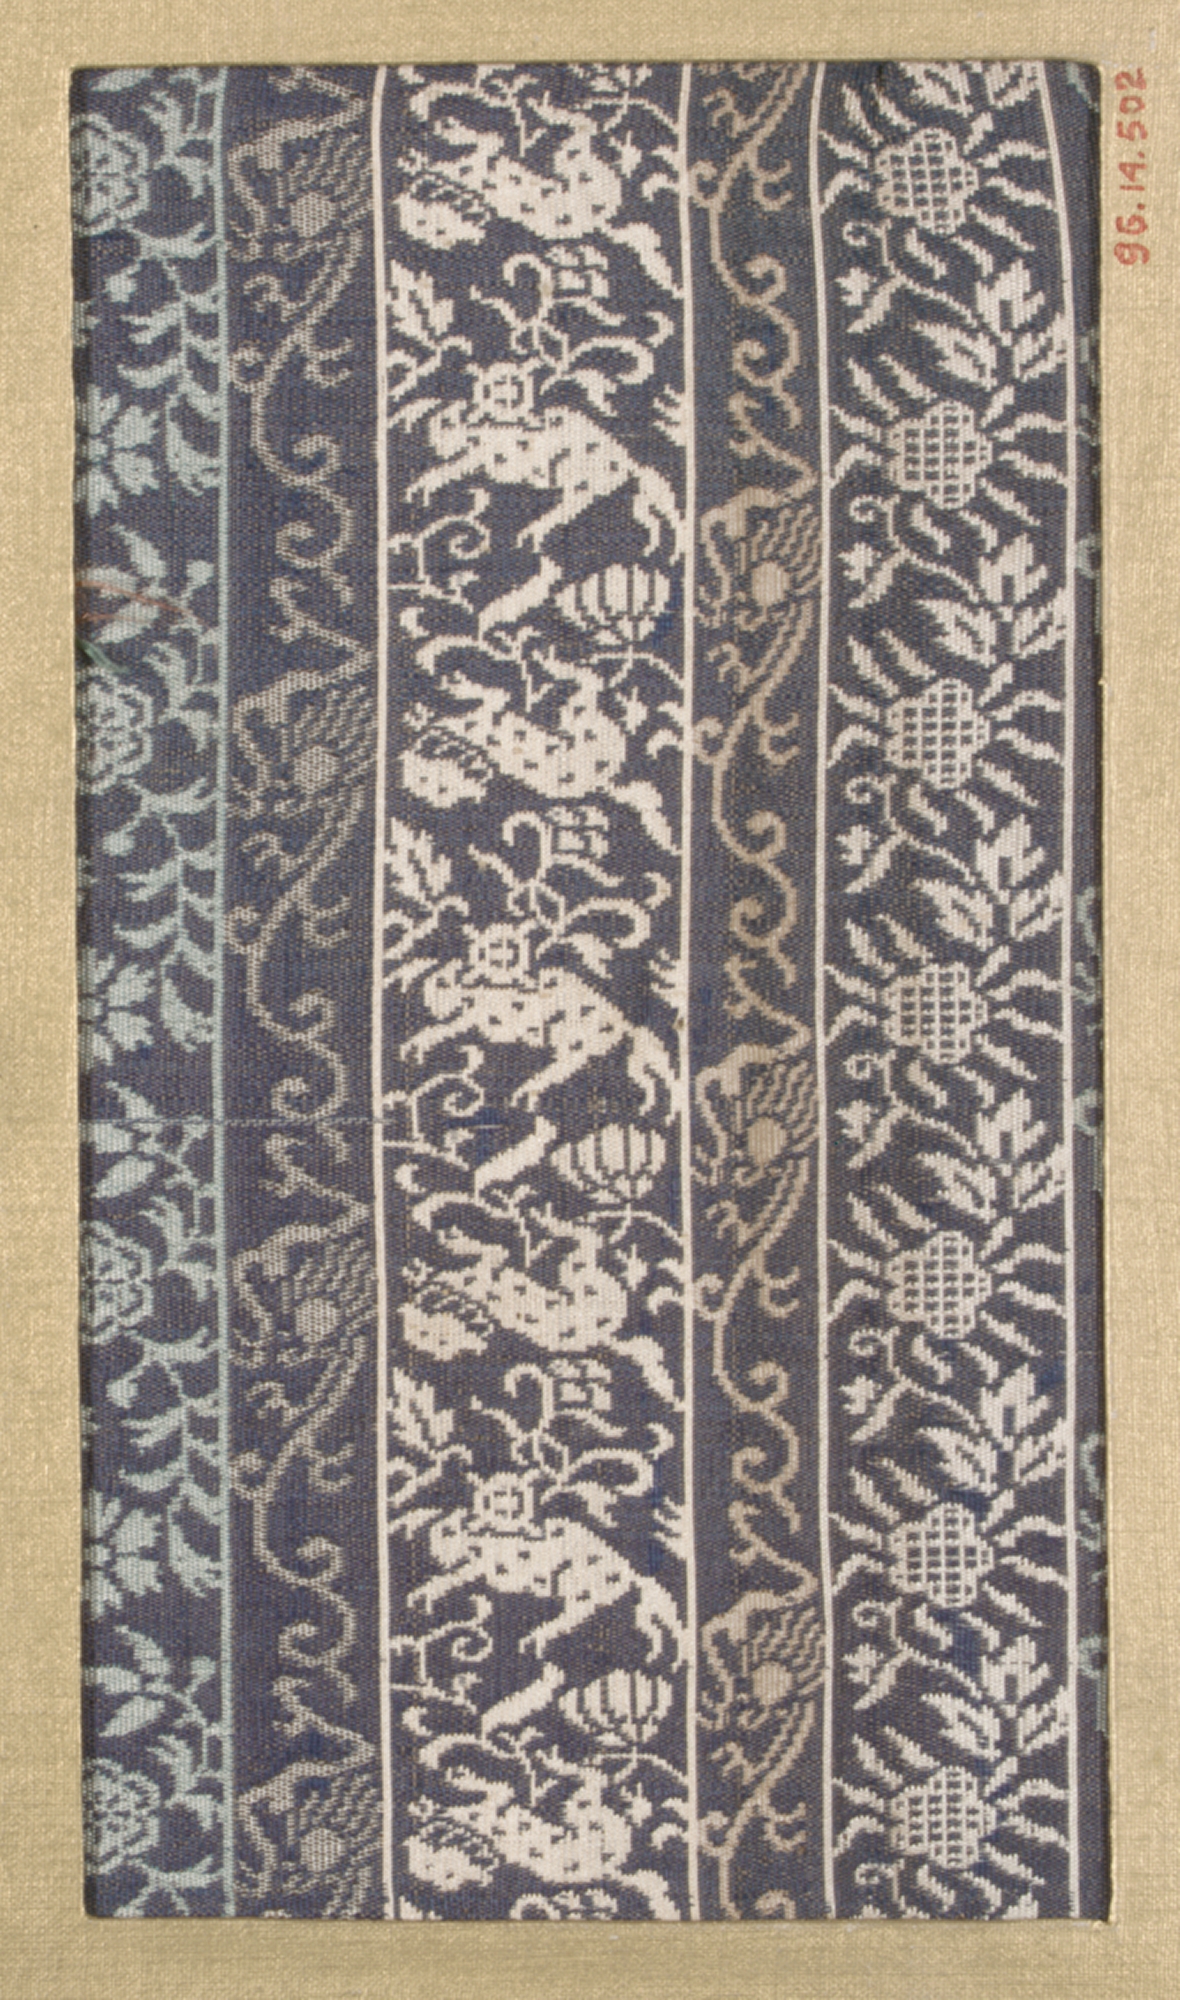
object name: piece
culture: japanese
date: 1701-1900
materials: silk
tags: leaves